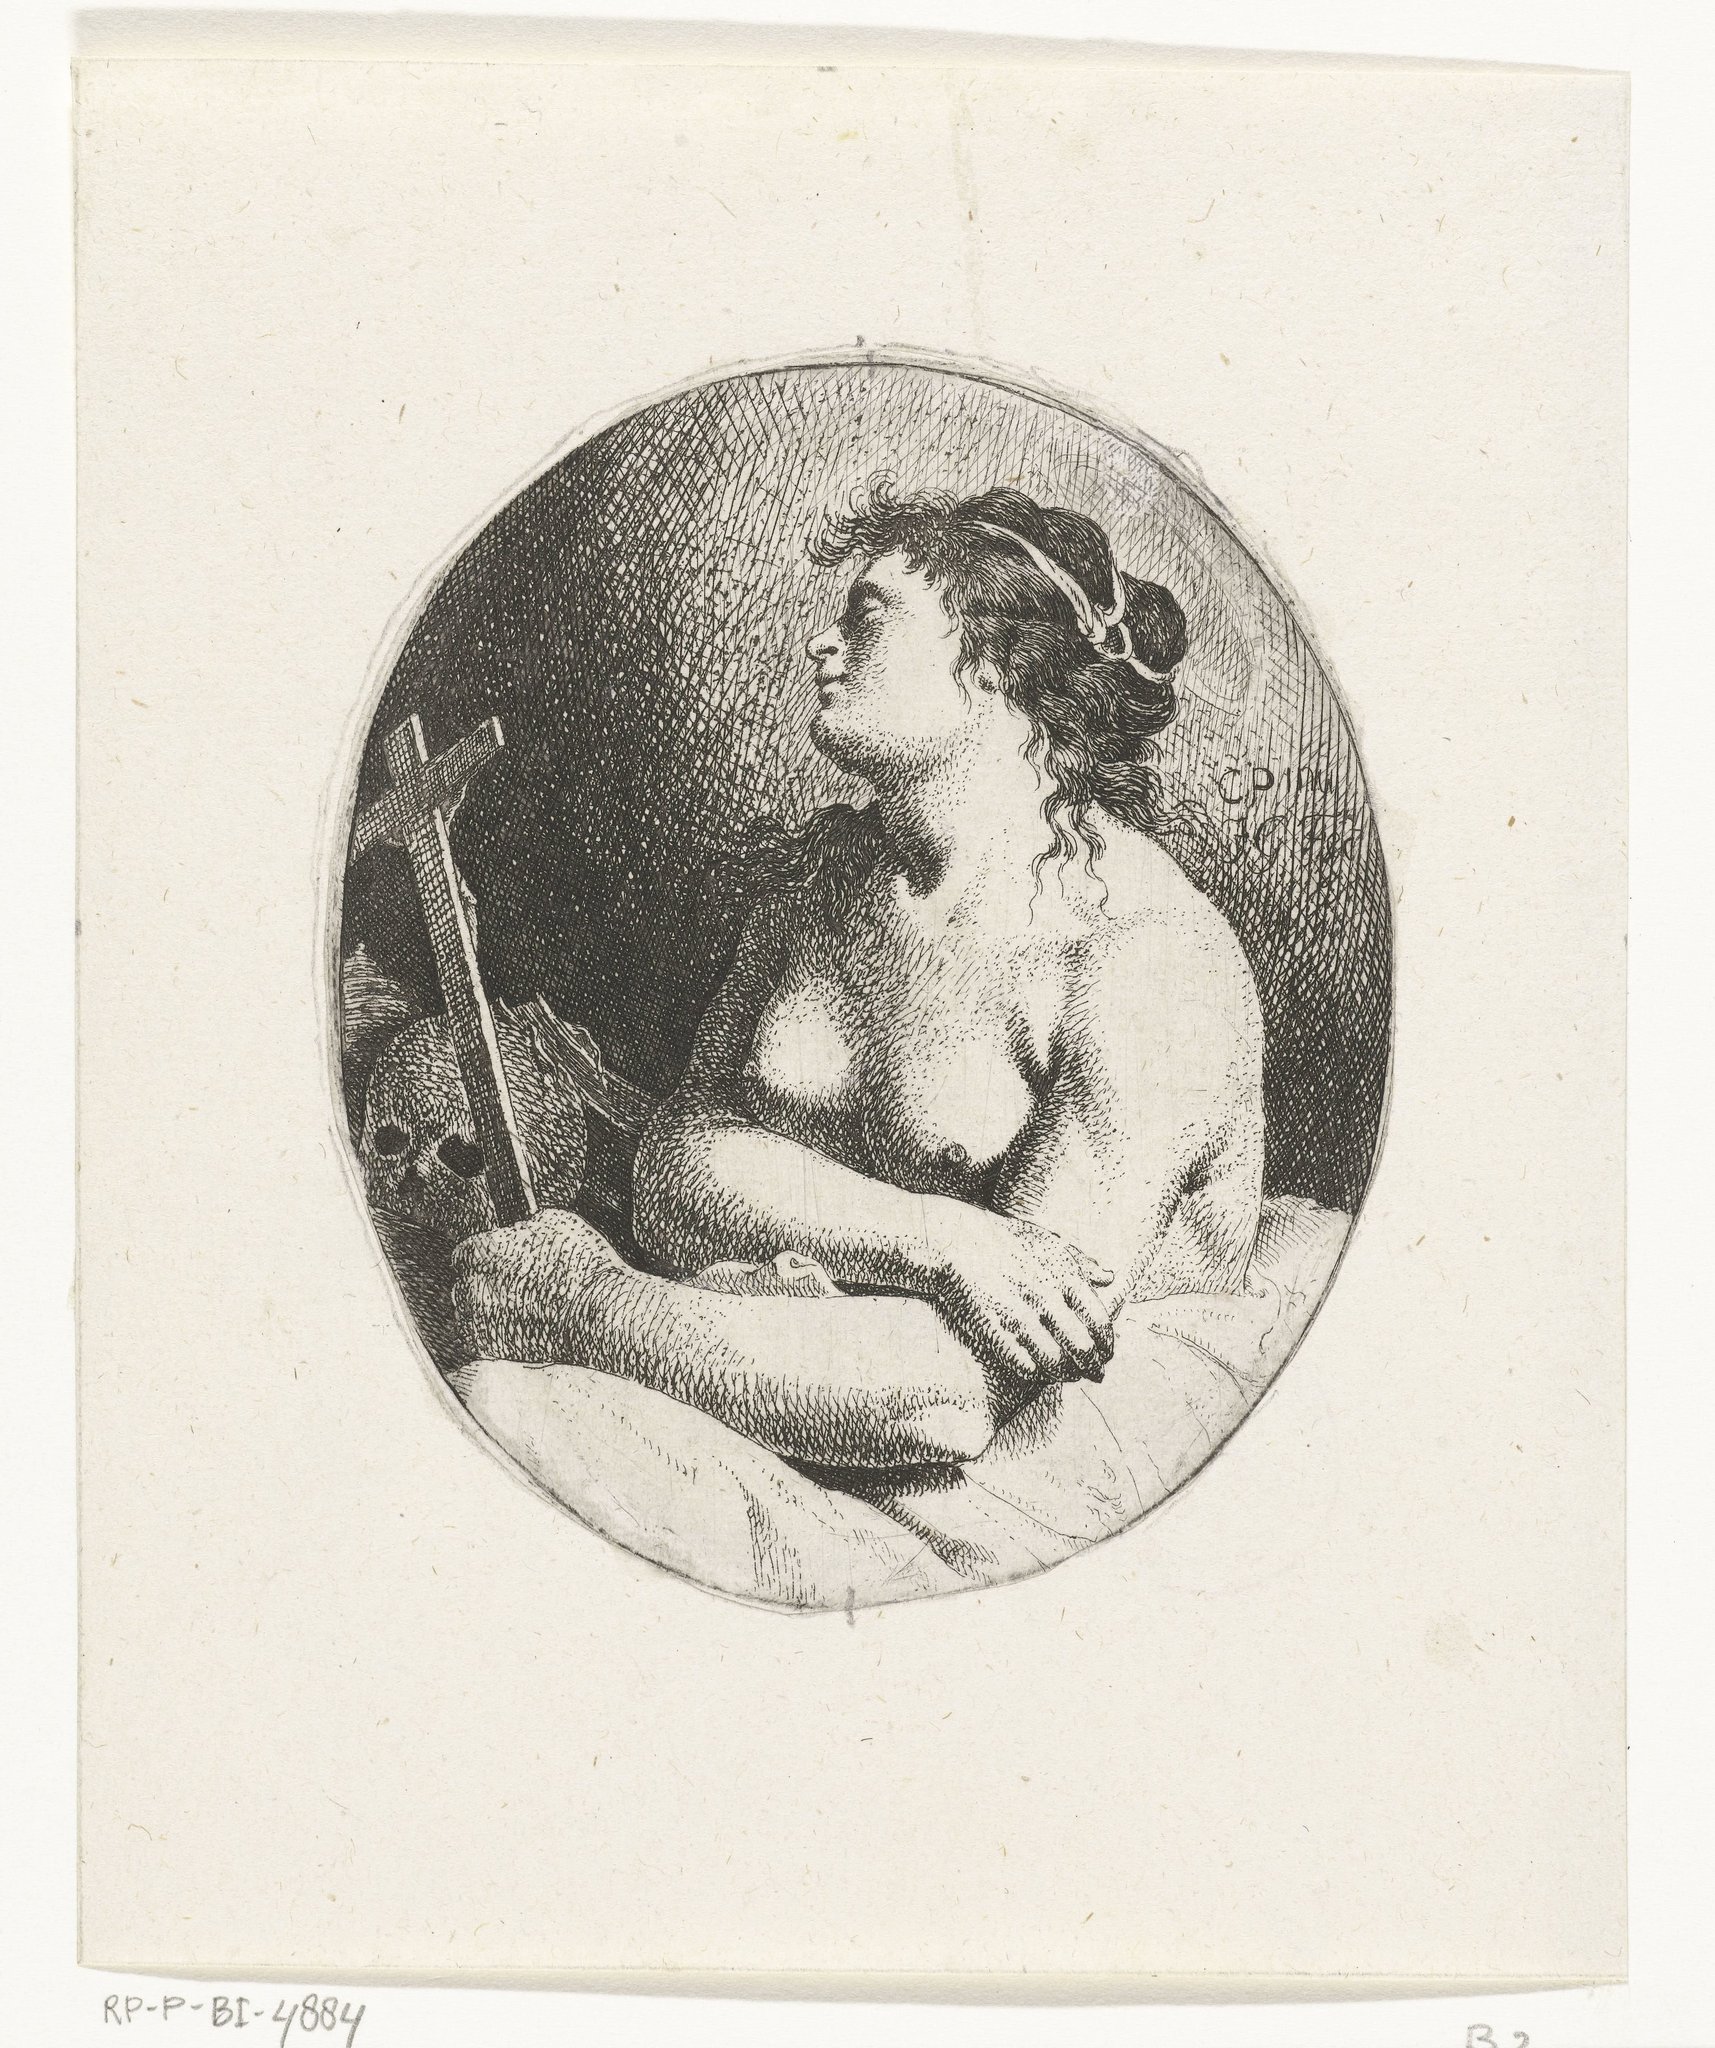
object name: print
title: Boetvaardige Maria Magdalena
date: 1613-1661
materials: paper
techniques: etching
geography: netherlands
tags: the penitent st. mary magdalene (often before a cave, possibly at la sainte-baume hill): her long hair covers her (naked) body, she reads, meditates or raises her tear-filled eyes towards heaven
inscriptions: collector's mark: Lugt 240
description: Prent naar ontwerp van Cornelis van Poelenburch.